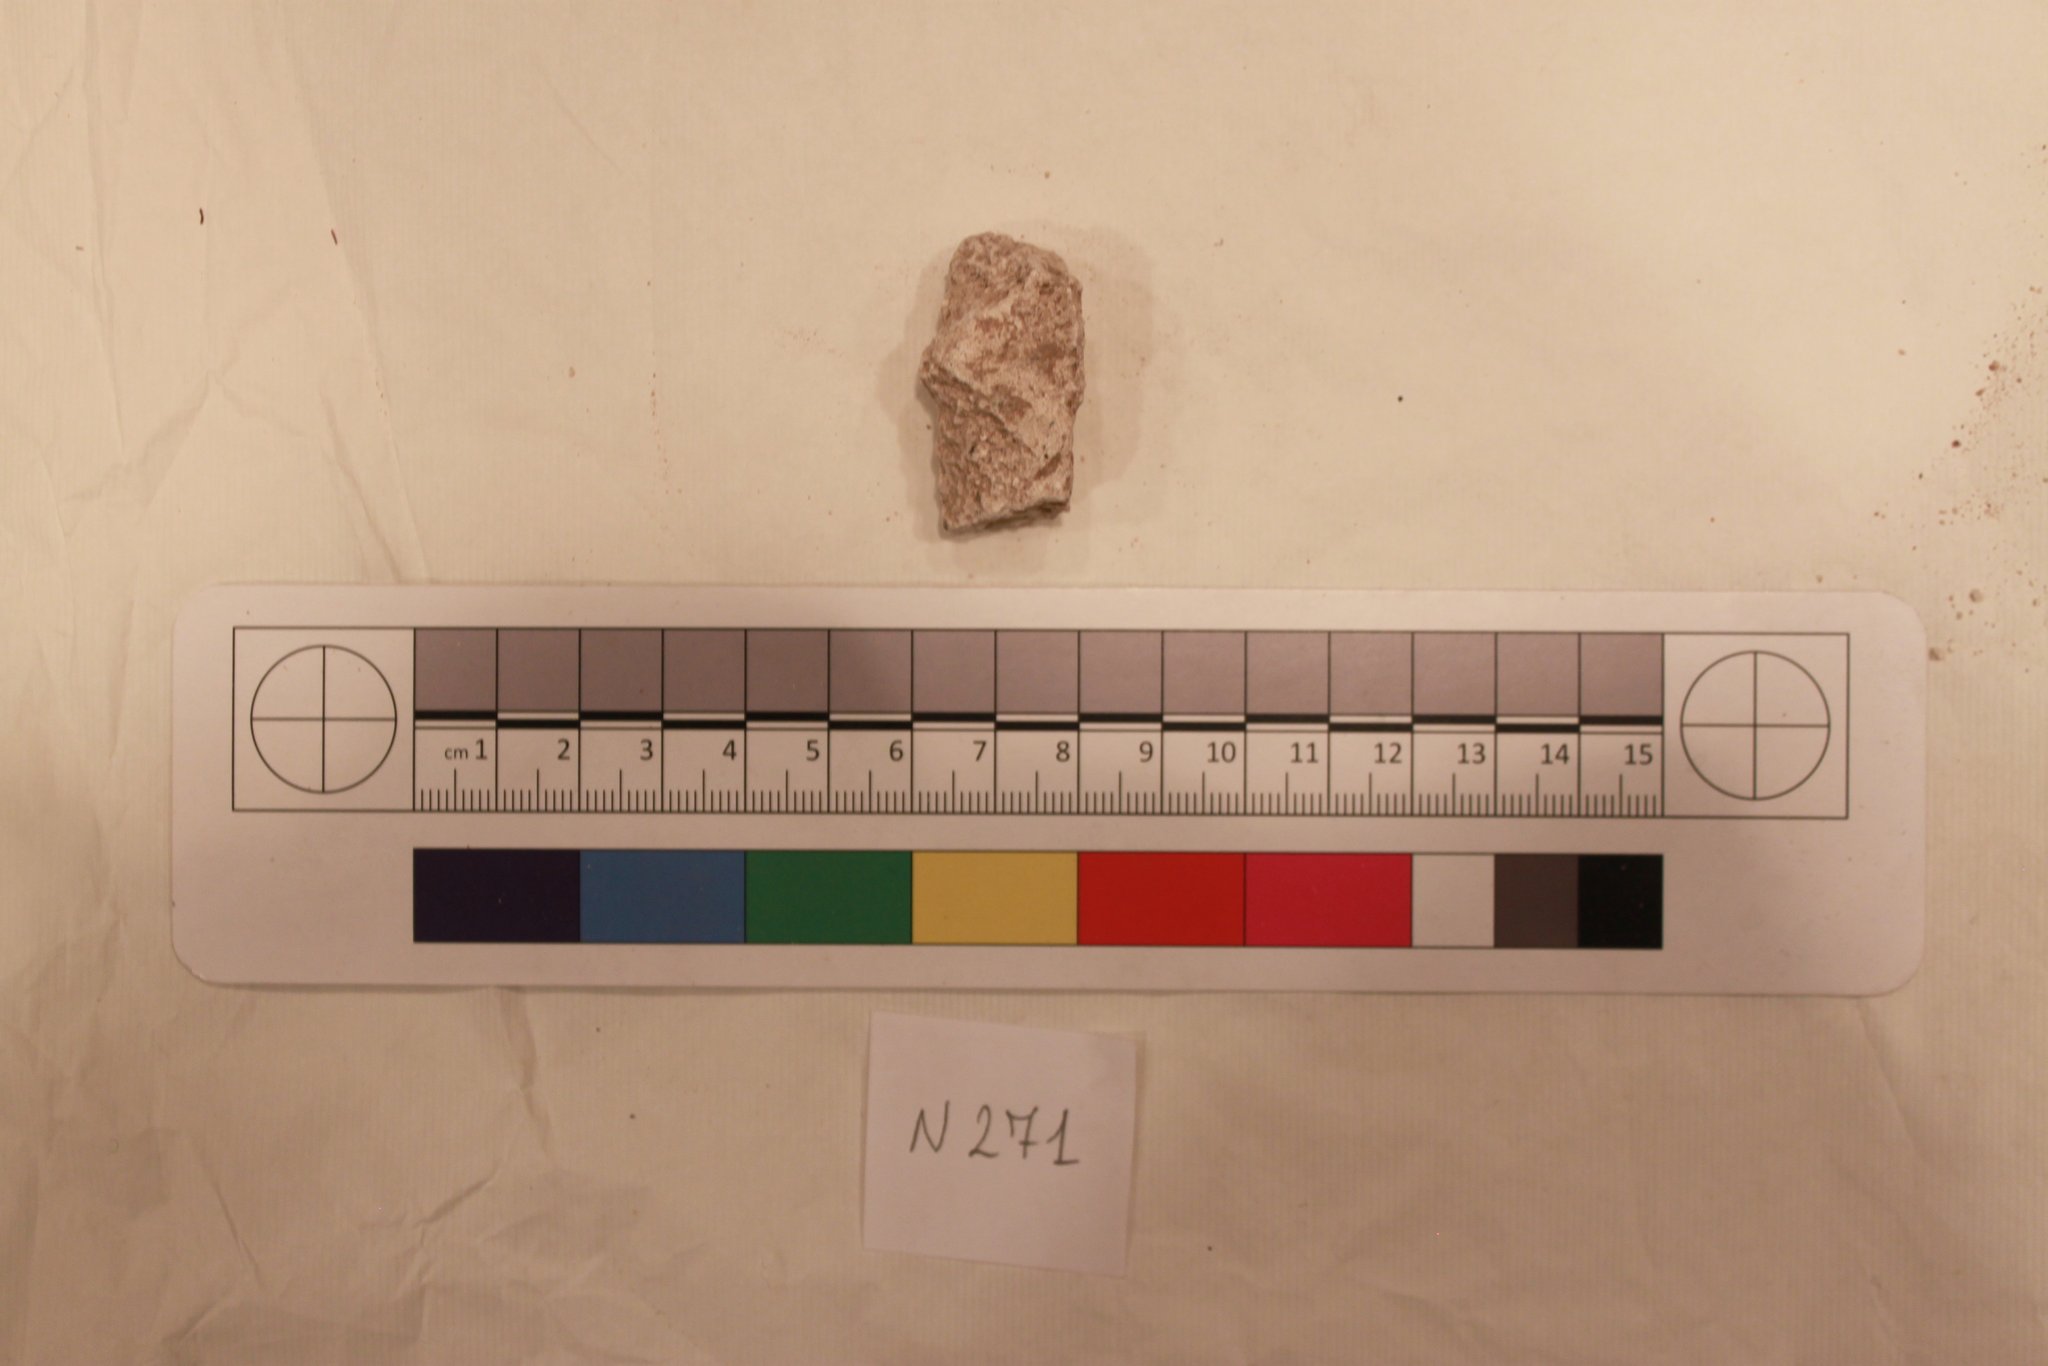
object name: fragment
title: Stucco Fragment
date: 701-1200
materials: plaster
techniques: carving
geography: iran